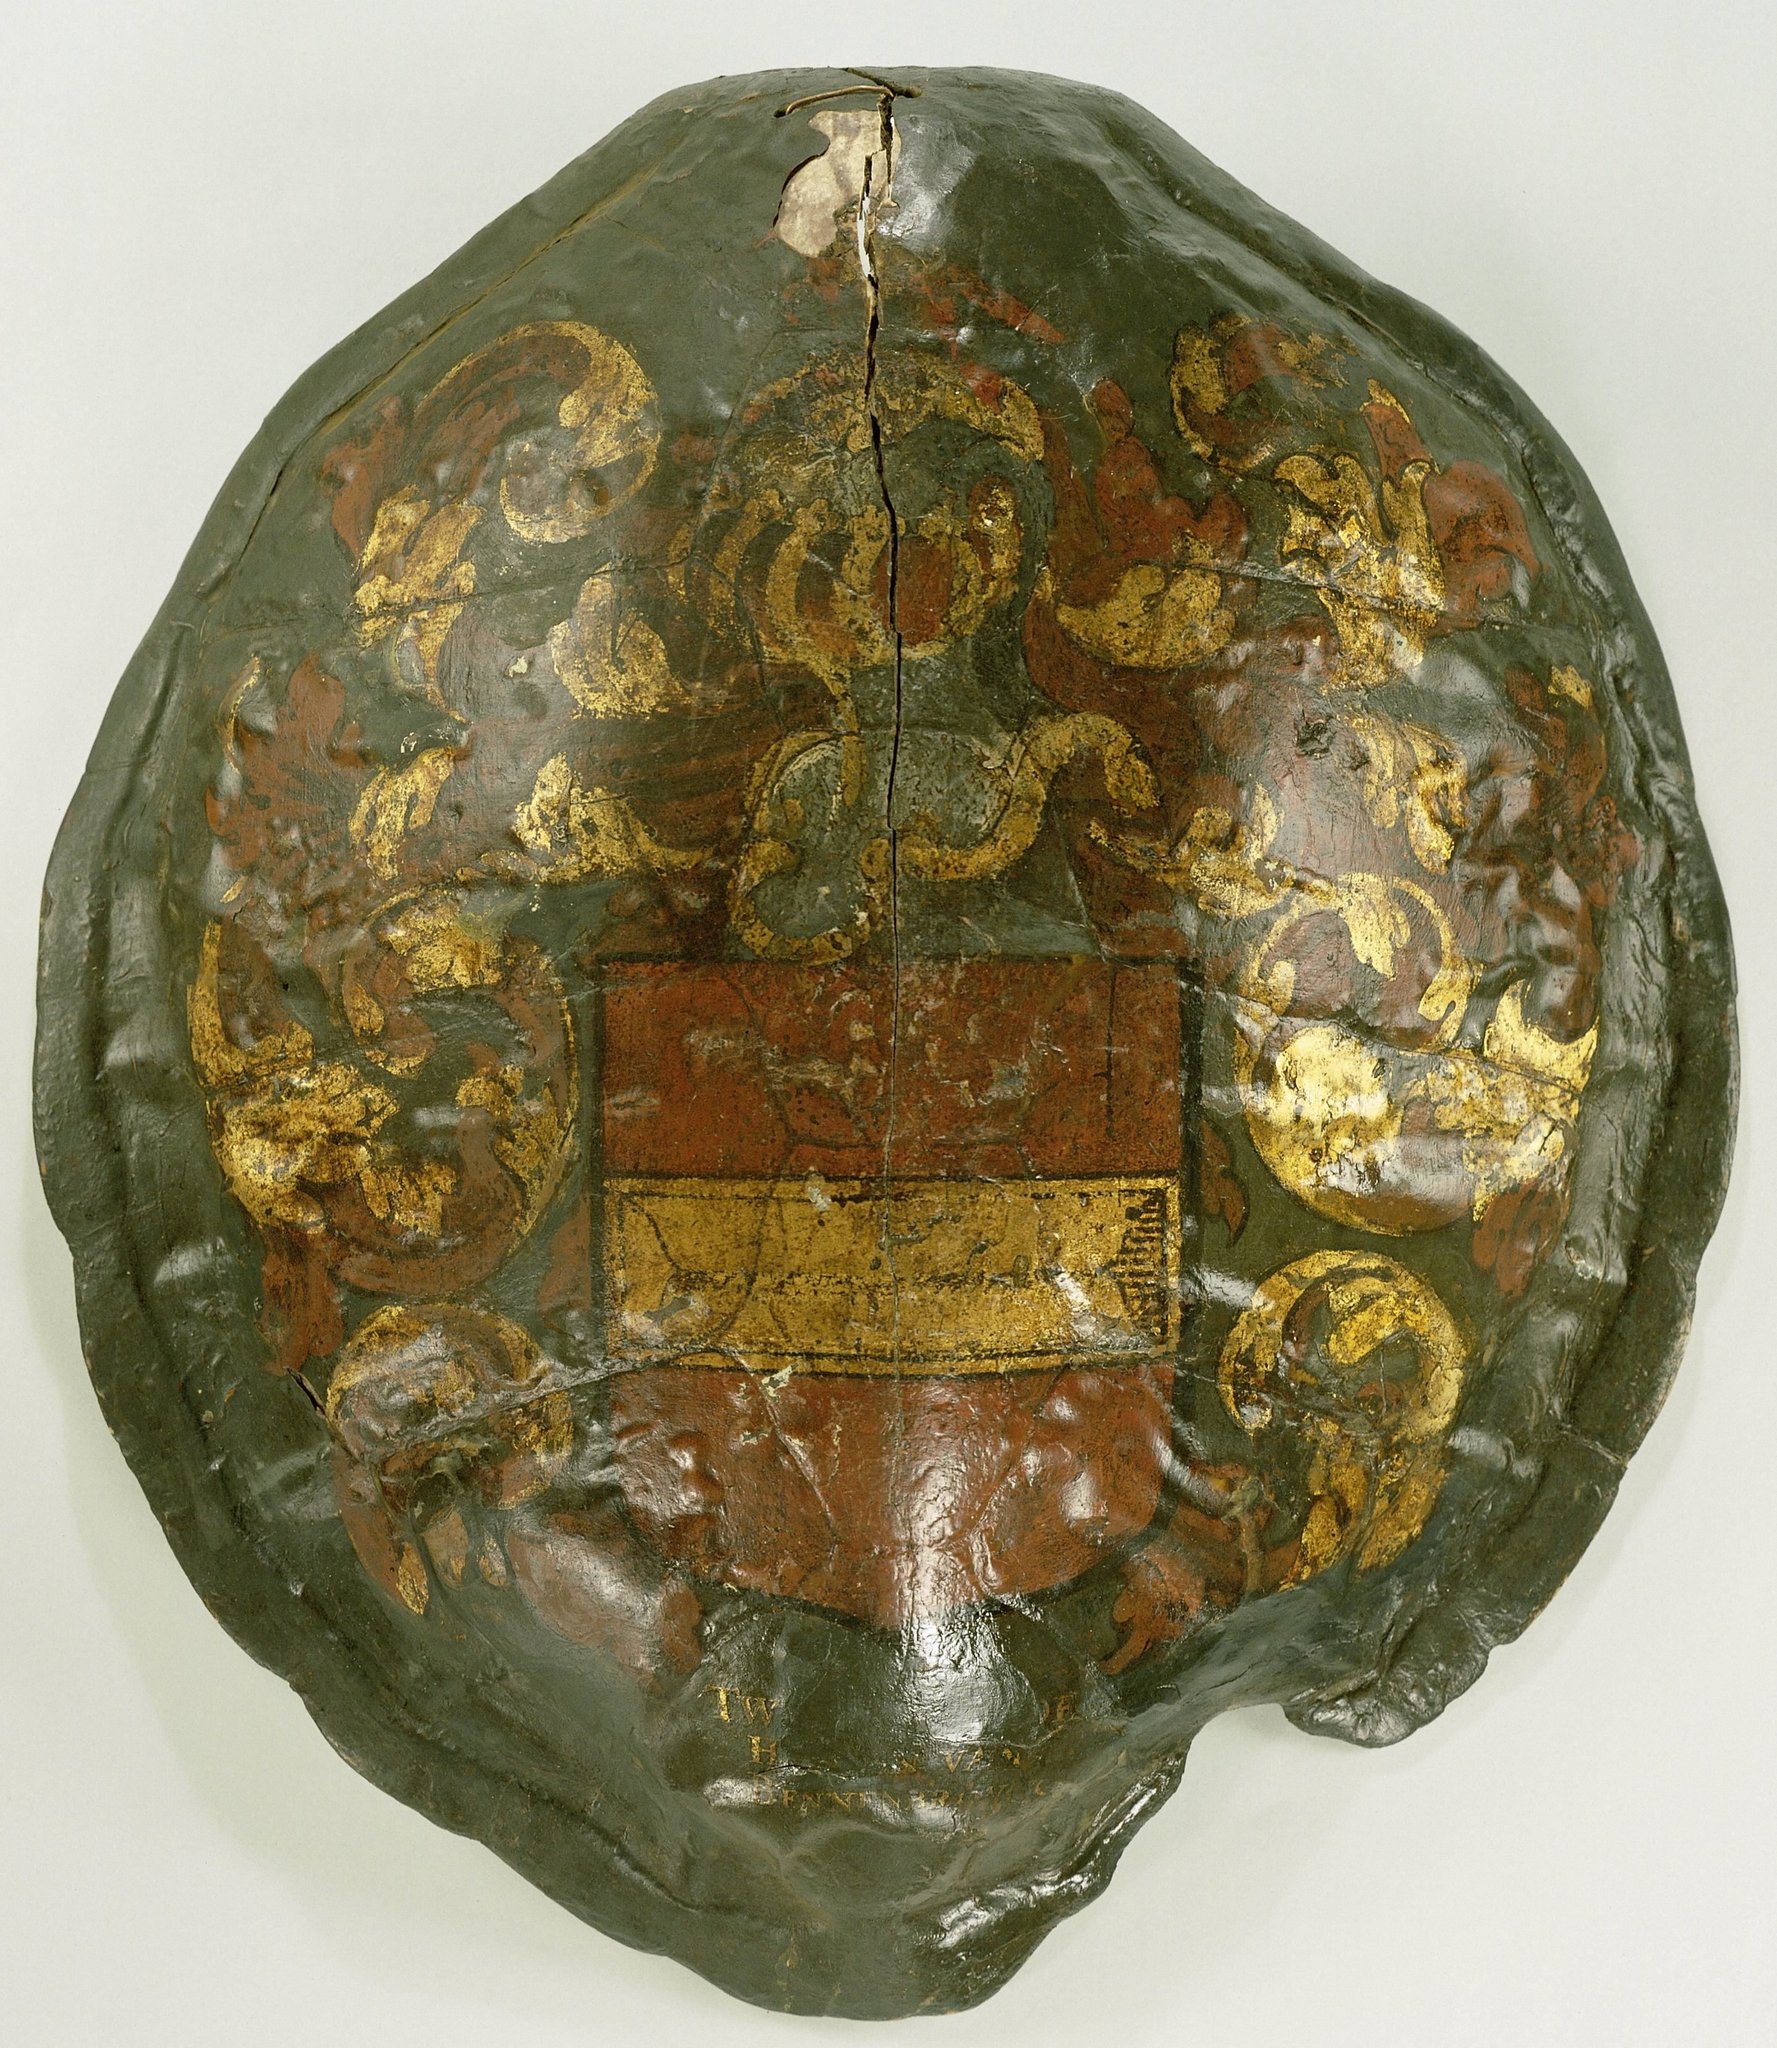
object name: schildpadrug, schildpadschaal, schildpadschild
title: Schildpadschaal met het wapen van de heren van Bennebroek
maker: Anonymous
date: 1500-1900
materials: shell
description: Schild van een schildpad met het geschilderde wapen van de heren van Bennebroek op de buitenkant. Van binnen is koperdraad bevestigd. Het wapen bestaat uit drie horizontale banen, boven en onder rood, midden goud. De dekkleden zijn ranken van rood, groen en goud. Opschrift onder het hartschild: 'Tw.....E// Heeren van// Bennebrouck.': in gouden letters met schaduwrand. Alles tegen een donkere achtergrond.